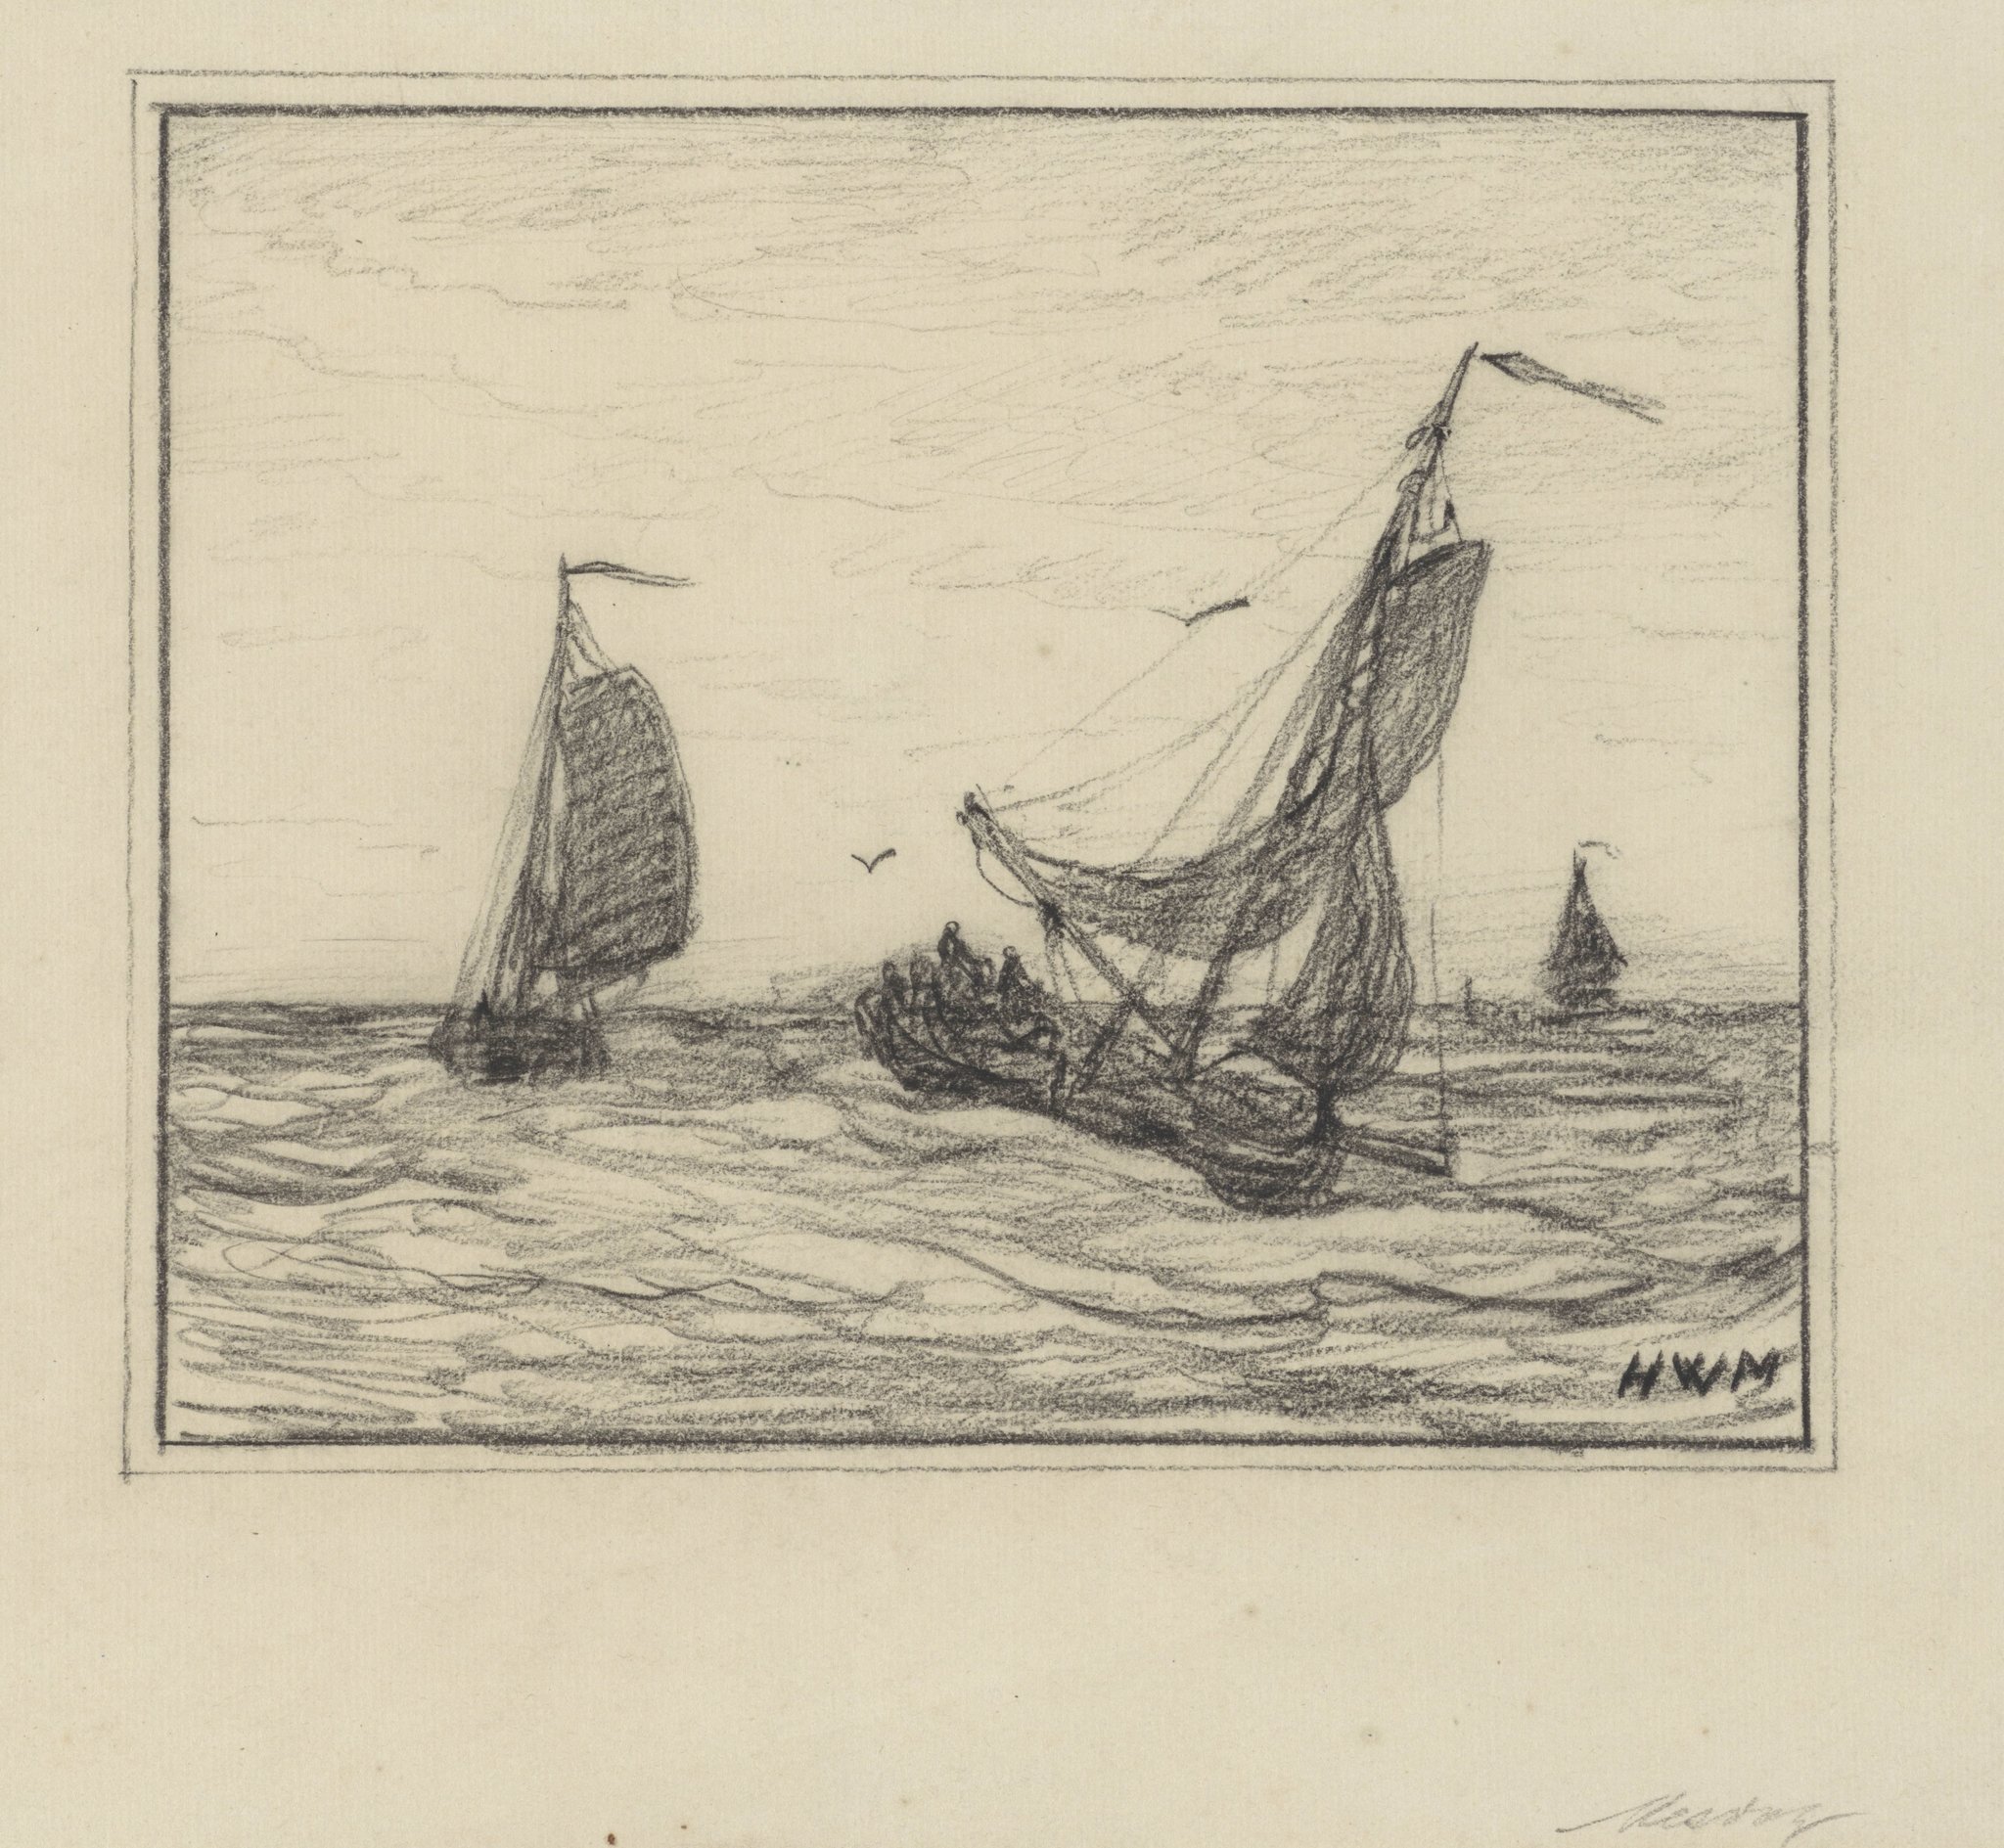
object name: drawing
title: Drie pinken op zee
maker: hendrik willem mesdag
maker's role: draughtsman, painter, print maker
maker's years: 1831-1915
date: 1841-1915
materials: chalk, paper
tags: sailing-ship, sailing-boat, sea (seascape)